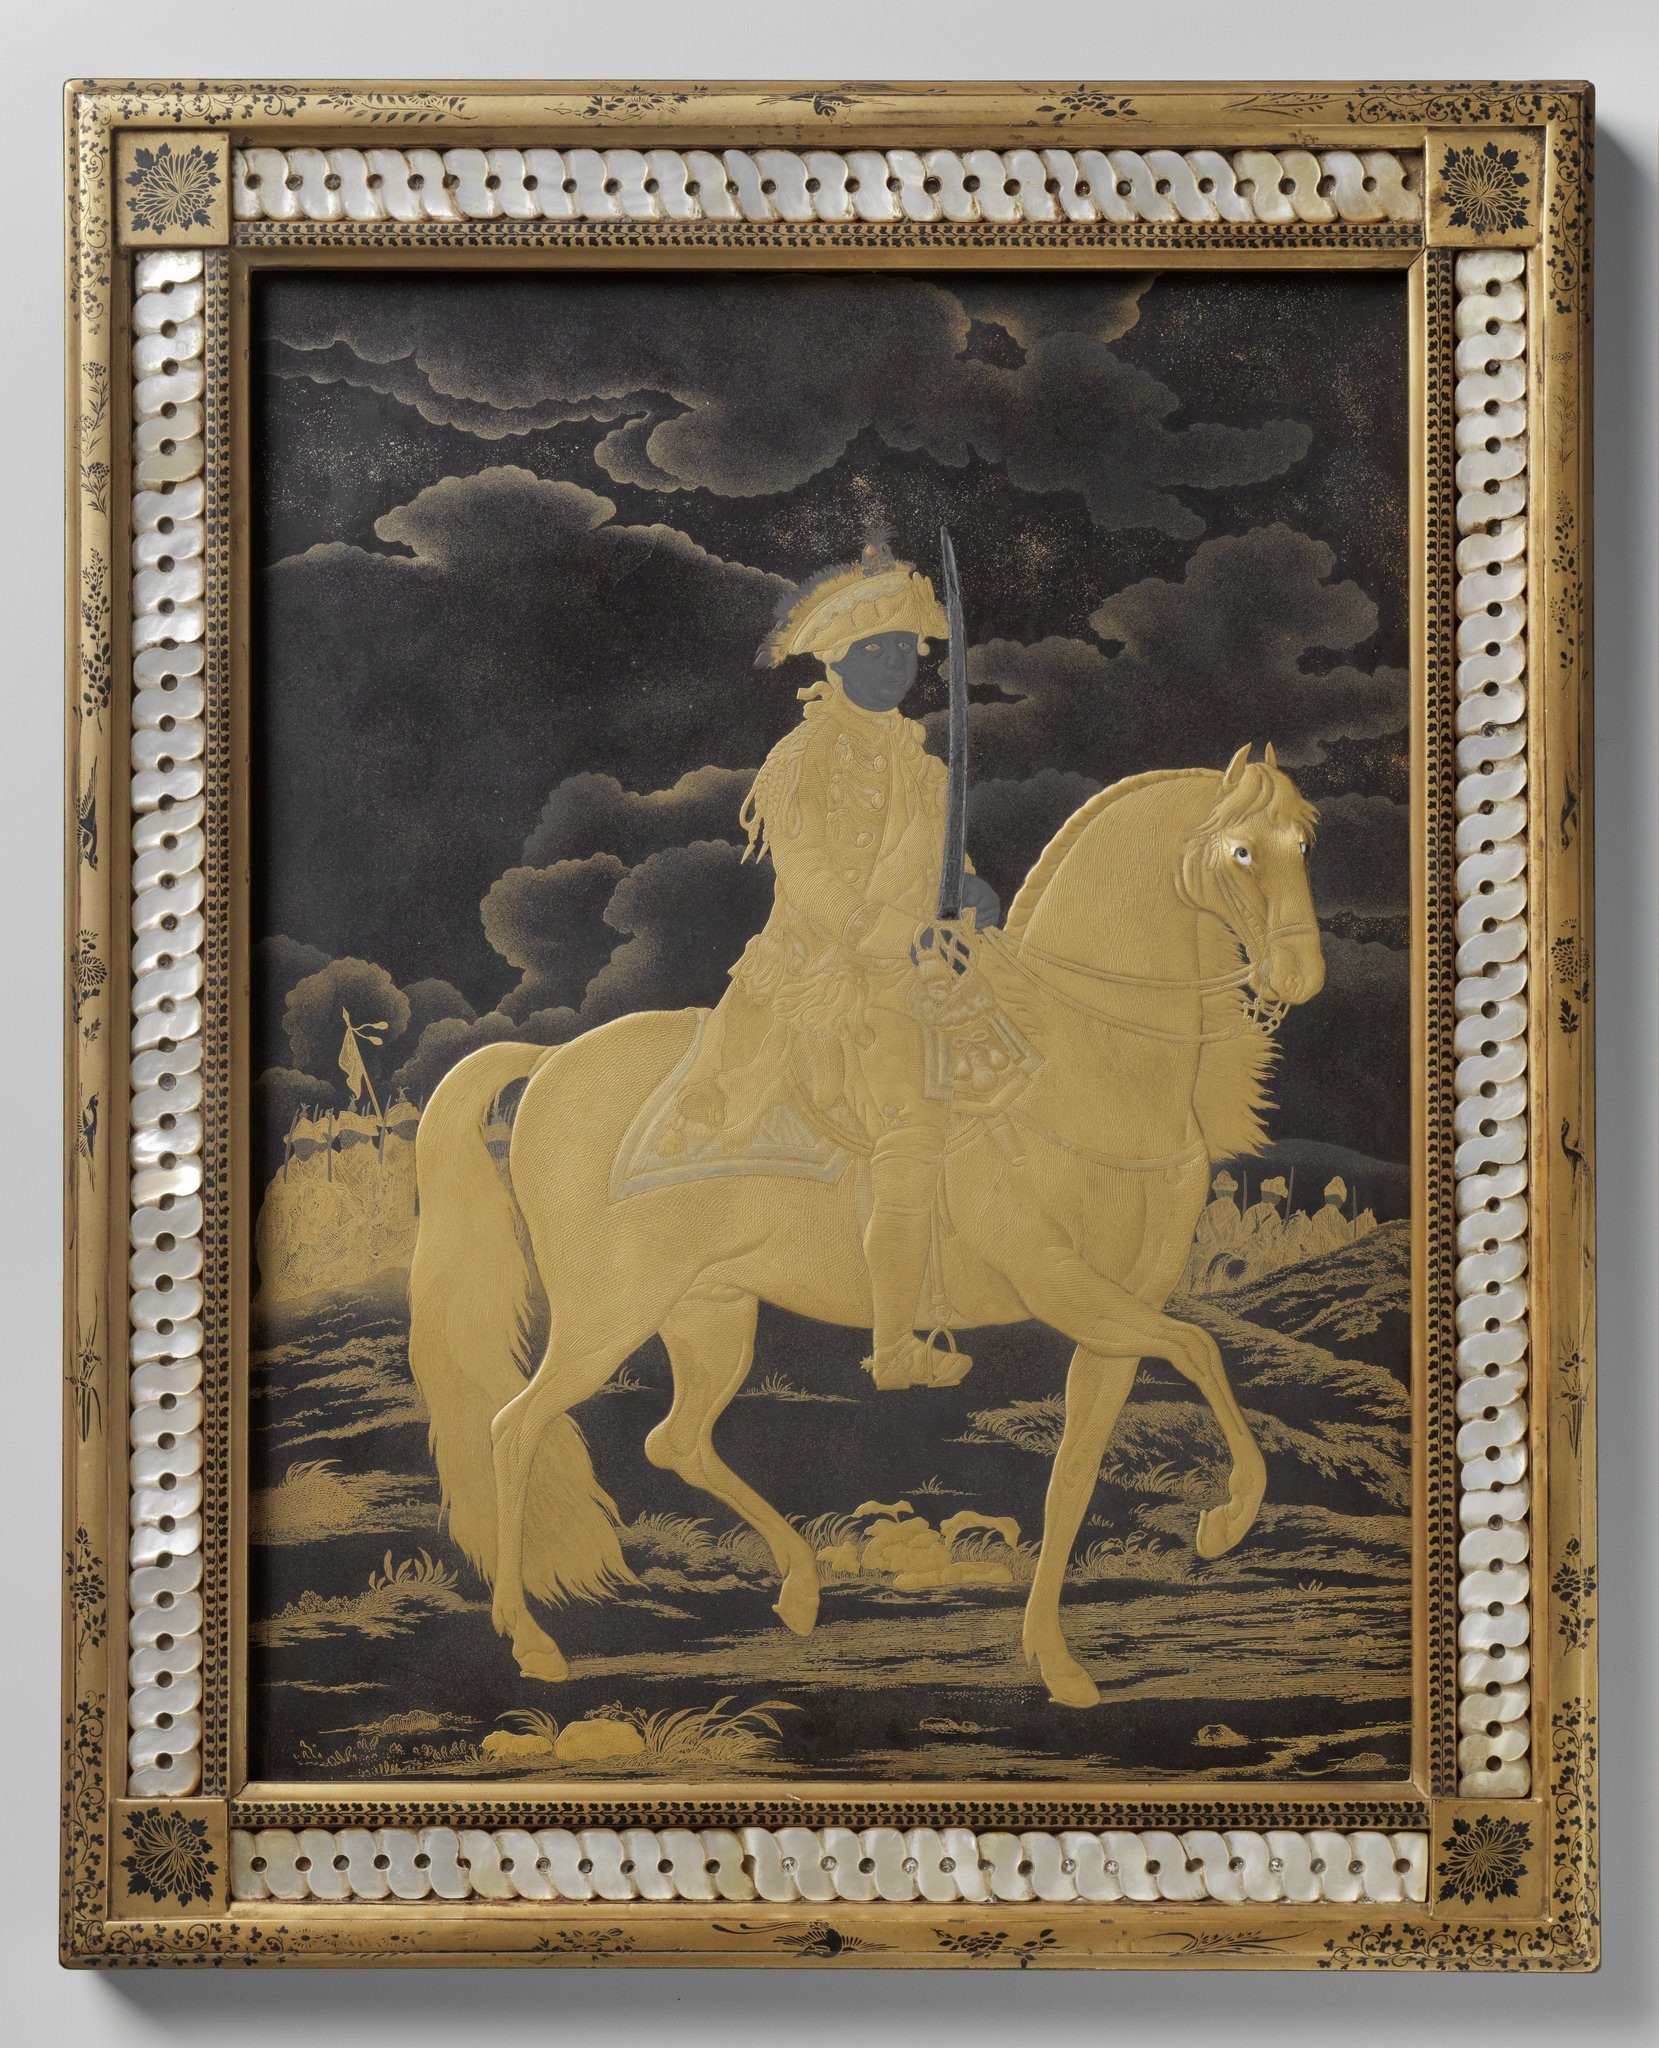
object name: lacquer panel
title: William V, Prince of Orange, on Horseback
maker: Anonymous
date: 1775-1800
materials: glass, lacquer, metal, mother of pearl, wood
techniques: cutting, gilding, lacquer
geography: japan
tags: the hague, william v (prince of orange), equestrian state-portrait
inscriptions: inscription: ‘HONI SOIT QUI MAL Y PENSE JE MAINTIENDRAI’, inscription: ‘WILLEM DE V PRINS / VAN ORANGE En NASSAU / ERFSTADHOUDER DER VERENIGDE NEDERLANDEN etc.’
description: Ruiter met steek op en getrokken sabel naar rechts. Op sabel, hoofd en handen na, geheel in goud. Ondergrond zwart met goud. Het paard heeft stukjes glas als ogen. Op de achtergrond links een groep ruiters frontaal gezien, rechts drie ruiters op de rug gezien. Heuvelig landschap onder hoge wolkenlucht. Keerzijde wapen met leeuwen en tropheeën met opschrift. Goudgelakte lijst.